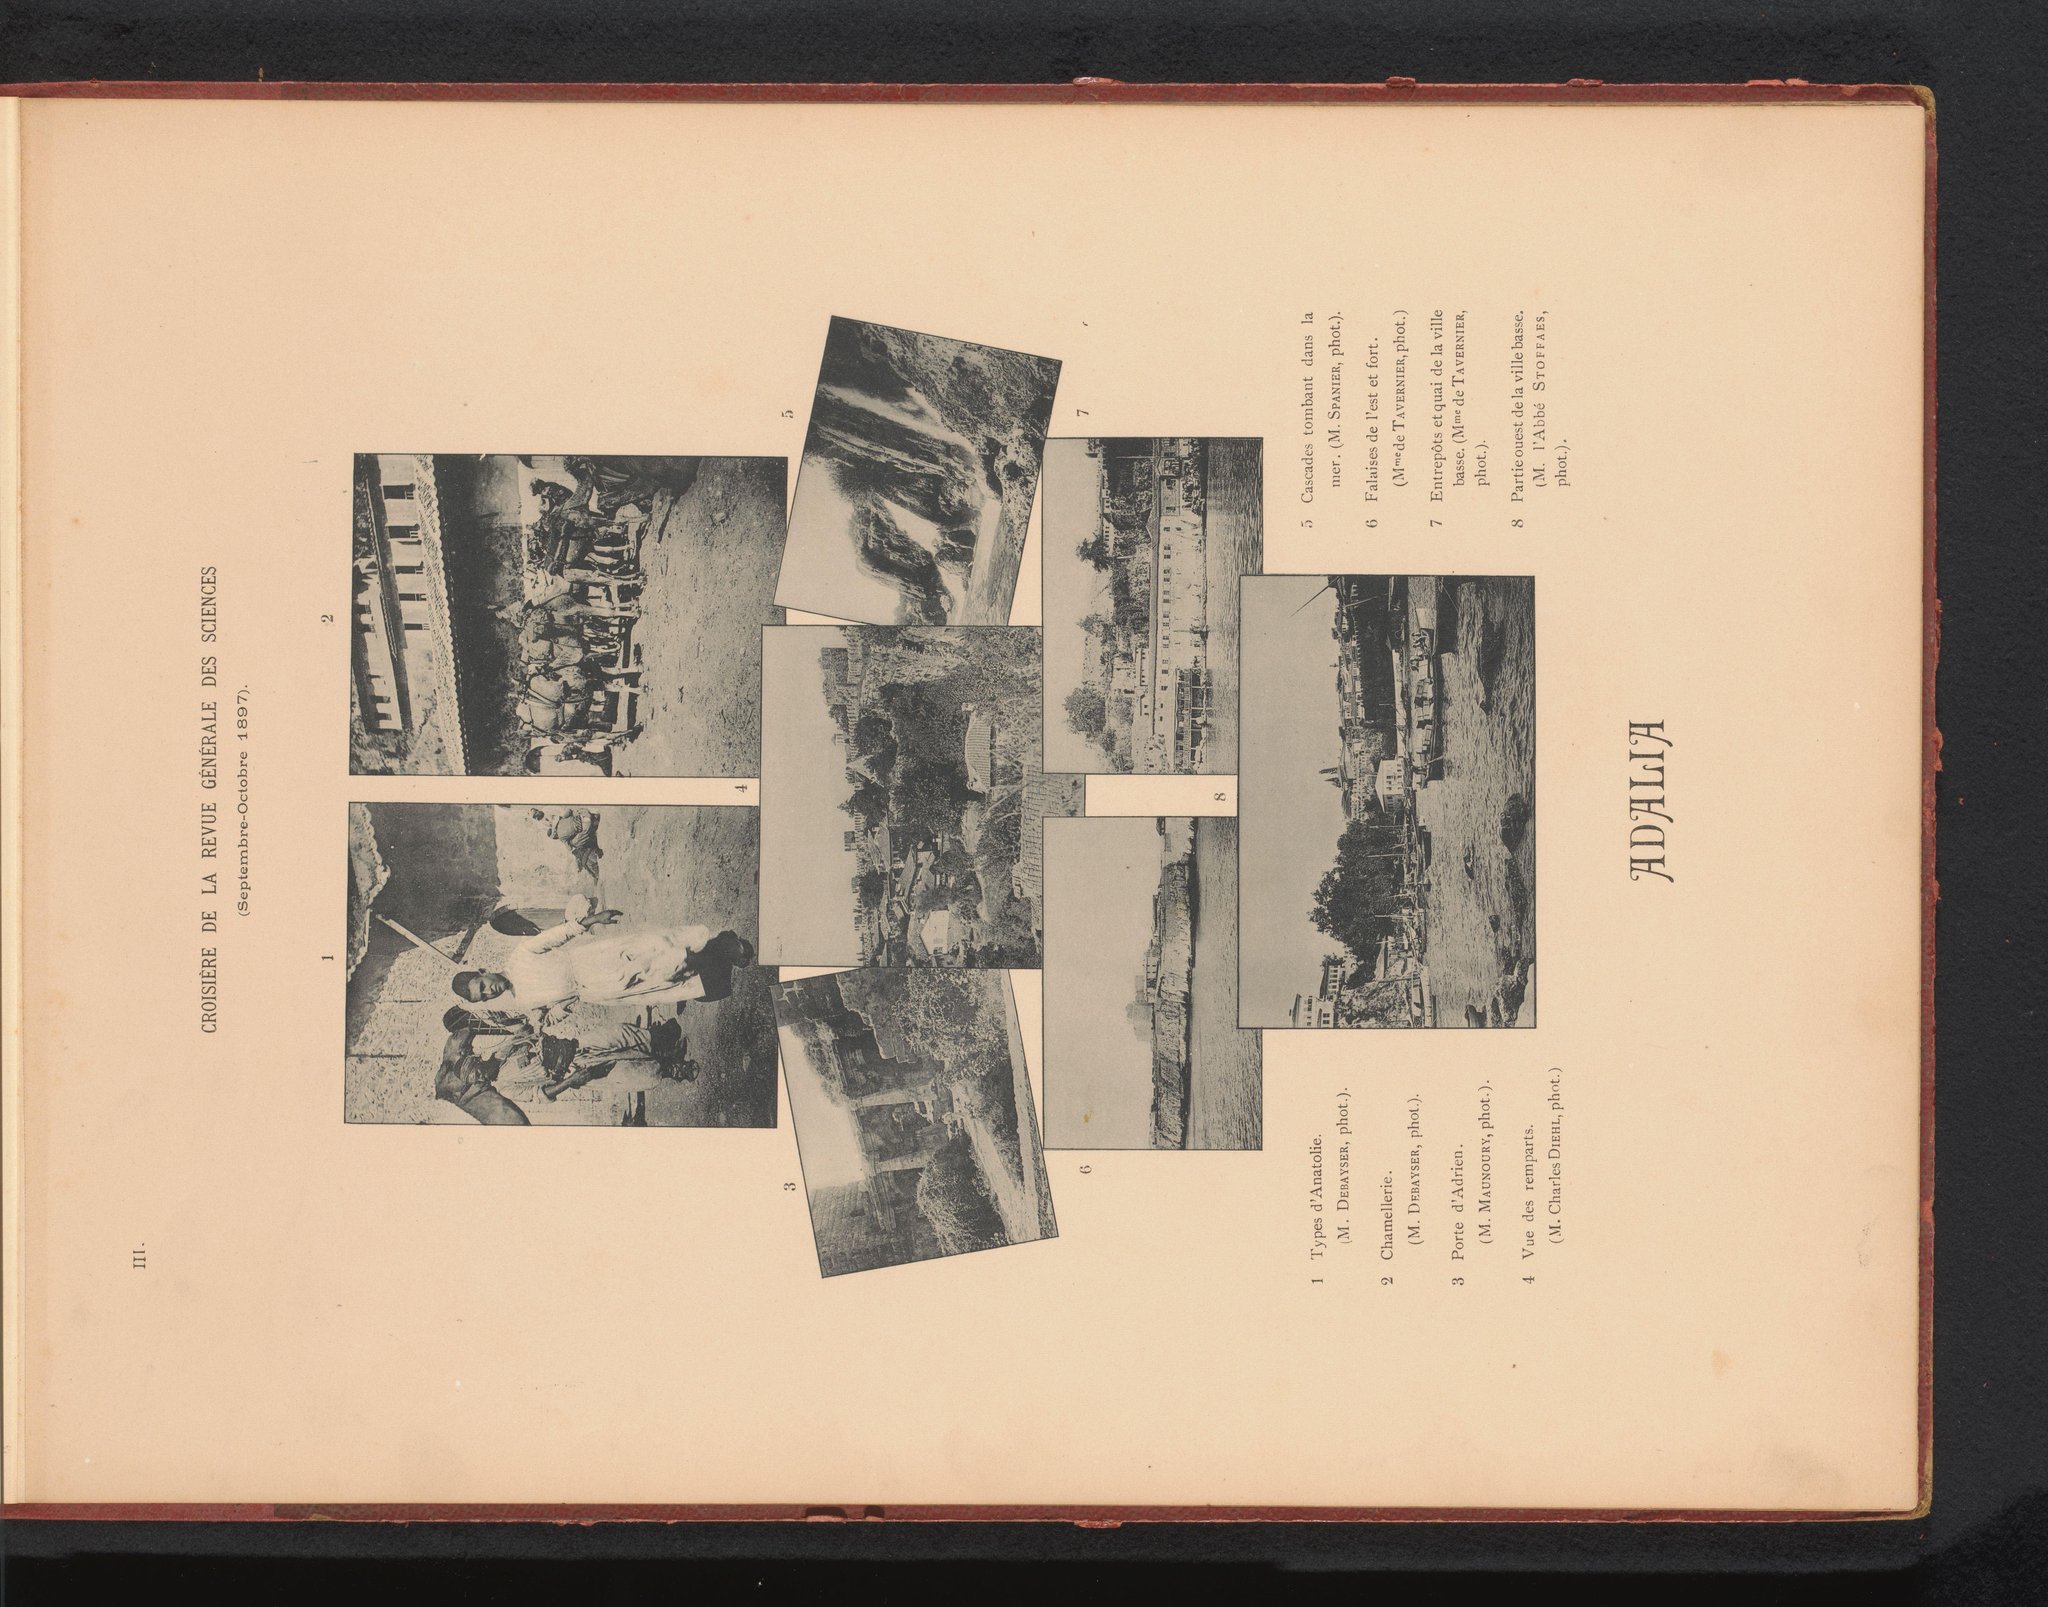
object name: photomechanical print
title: Acht gezichten op Adalia, Spanje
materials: paper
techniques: photograph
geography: paris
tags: prospect of village, silhouette of village, coast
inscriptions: inscription: ‘1 Types d'Anatolie./ (M. Debayser, phot.)./ 2 Chamellerie./ (M. Debayser, phot.)./ Porte d'Adrien./ (M. Maunoury, phot.)./ 4 Vue des remparts./ (M. Charles Diehl, phot.)./ 5 Cascades tombant dans la/ mer. (M. Spanier, phot.)./ 6 Falaises de l'est et fort./ (Mme de Tavernier, phot.)./ 7 Entrepôts et quai de la ville/ basse. (Mme de Tavernier,/ phot.)./ 8 Partie ouest de la ville basse./ (M. l'Abbé Stoffaes,/ phot.).’, number: ‘III.’